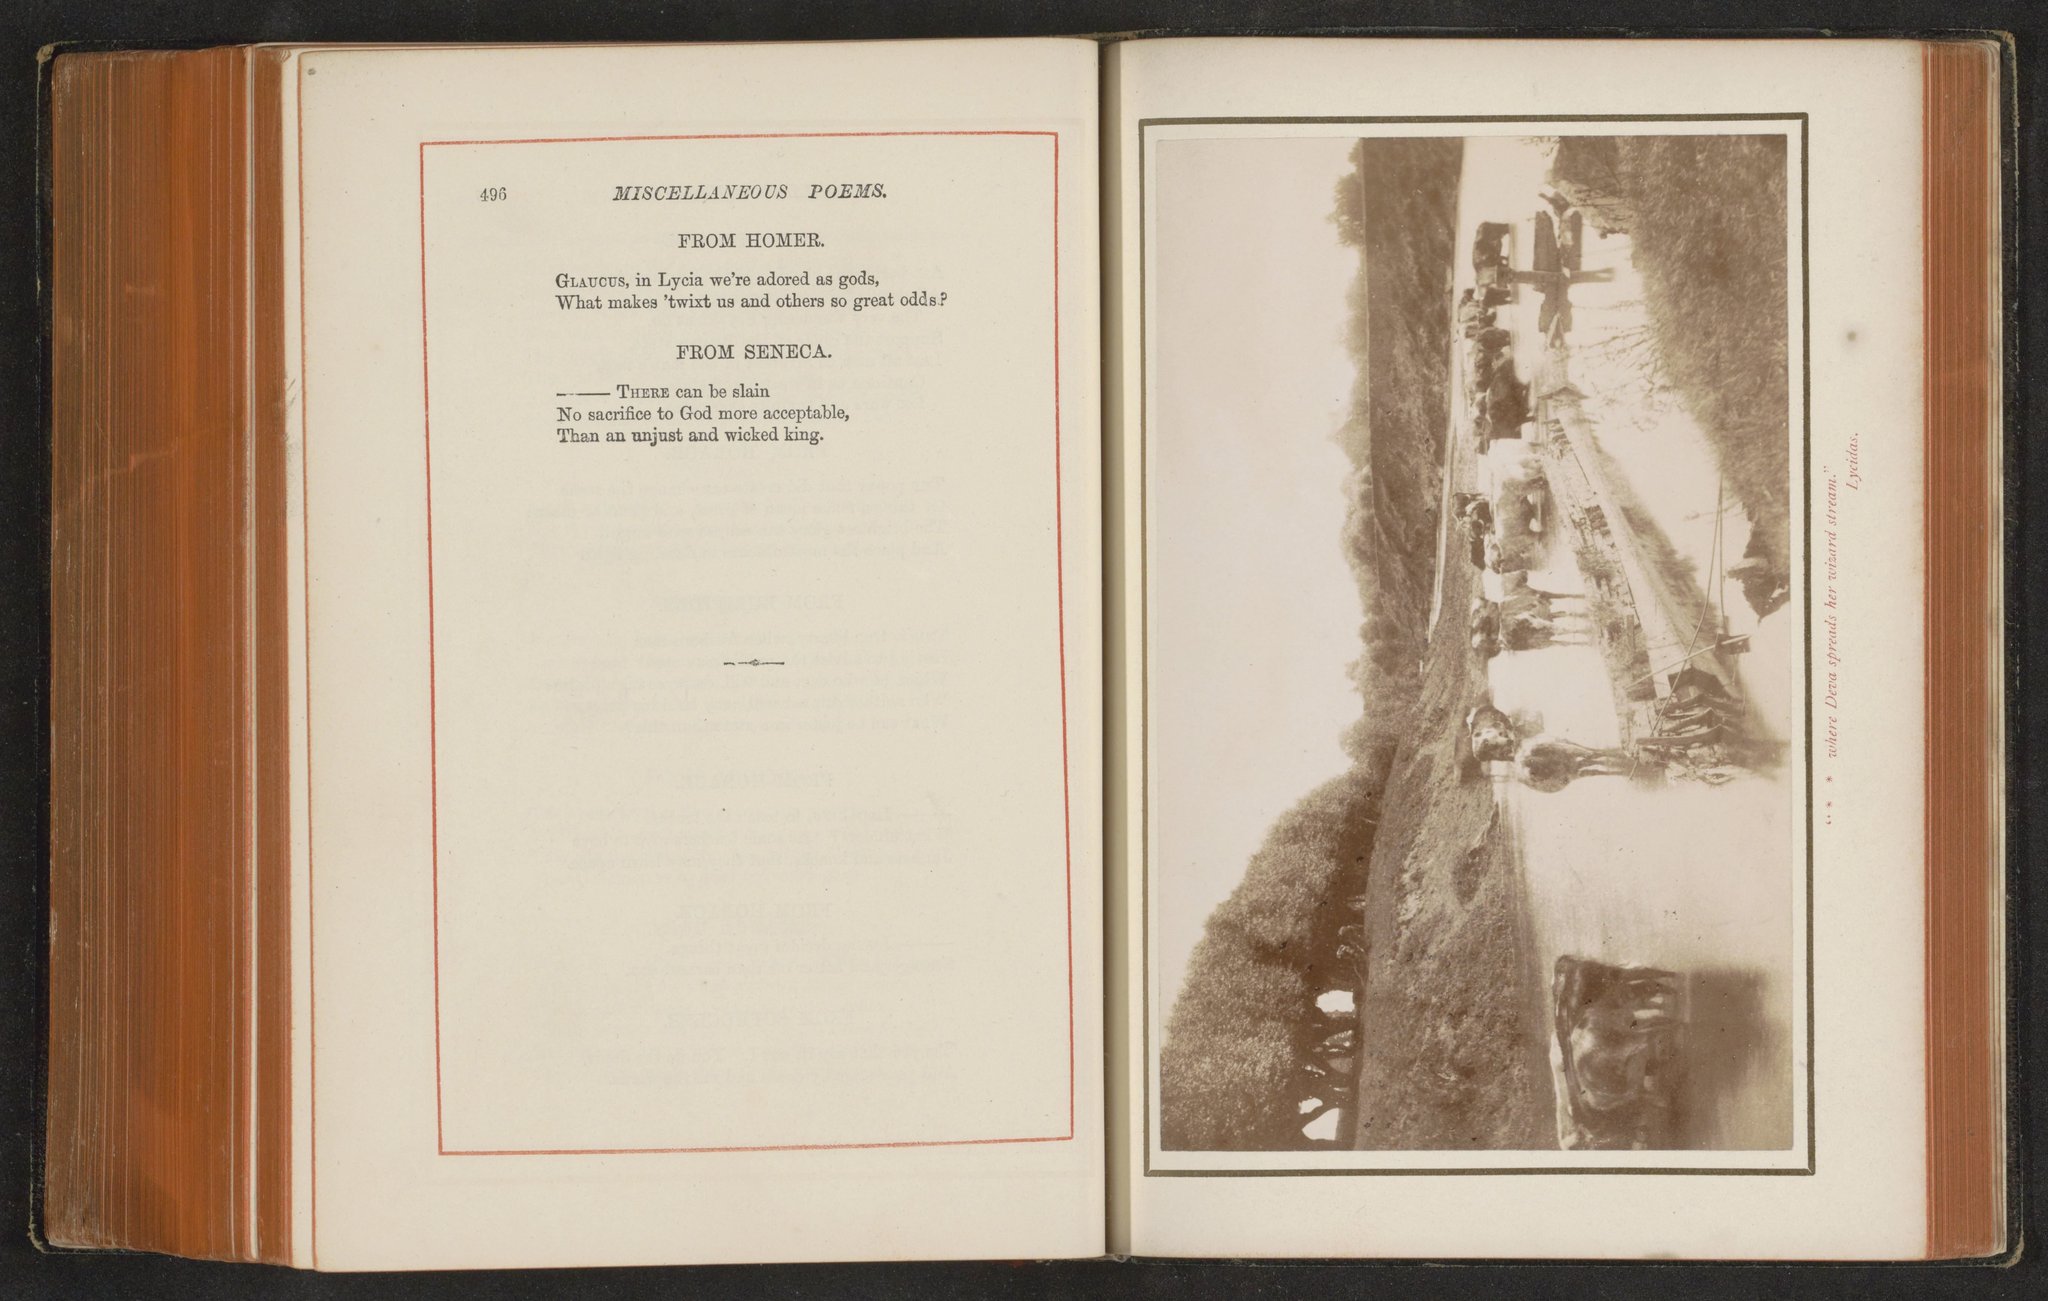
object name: photograph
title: Koeien in overstroomde weide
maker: deswall vaughan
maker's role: fotograaf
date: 1875-1885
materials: photographic support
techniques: albumen print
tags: cow, water meadows under water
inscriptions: inscription: ‘"* * where Deva spreads her wizard stream." Lycidas.’